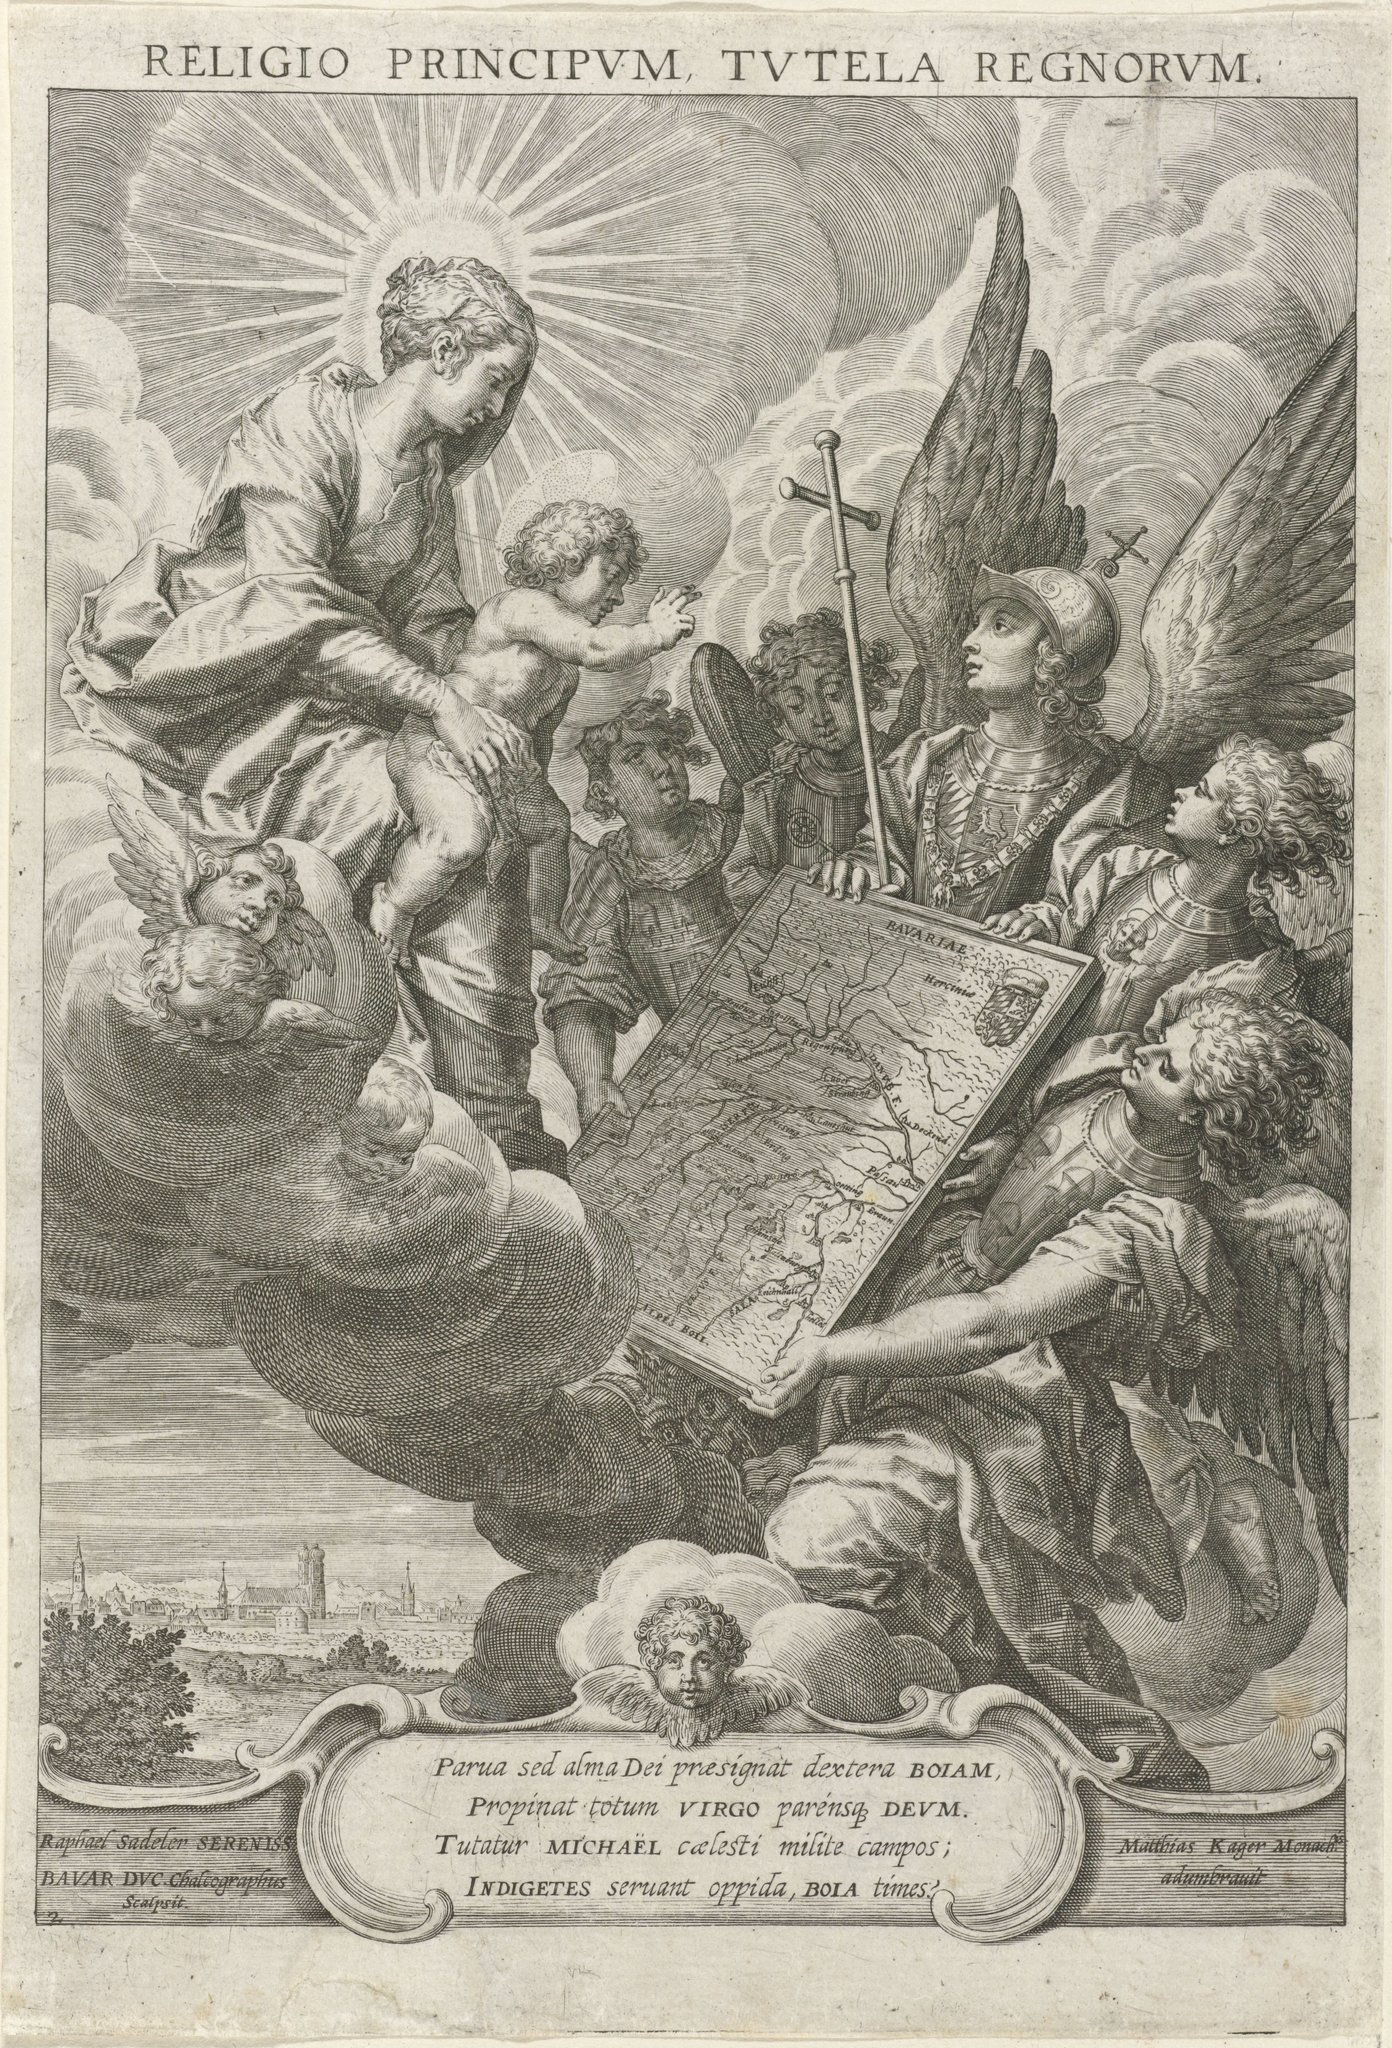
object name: print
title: Heiligen van Beieren I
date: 1615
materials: paper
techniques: engraving, etching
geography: munich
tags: madonna: mary sitting or enthroned, the christ-child in her lap (or in front of her bosom) (mary sometimes represented half-length), maps of separate countries or regions, the archangel michael (often in armour with sword or lance), angels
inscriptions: collector's mark: Lugt 240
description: Samen met andere engelen presenteert aartsengel Michael de kaart van het hertogdom Beieren aan de maagd Maria en het Christuskind in de wolken. Het Christuskind maakt een zegenend gebaar. Op de achtergrond linksonder München, de hoofdstad van Beieren. De prent heeft een Latijns onderschrift in een cartouche en is de tweede prent van een 60-delige serie met als onderwerp de heiligen van Beieren.